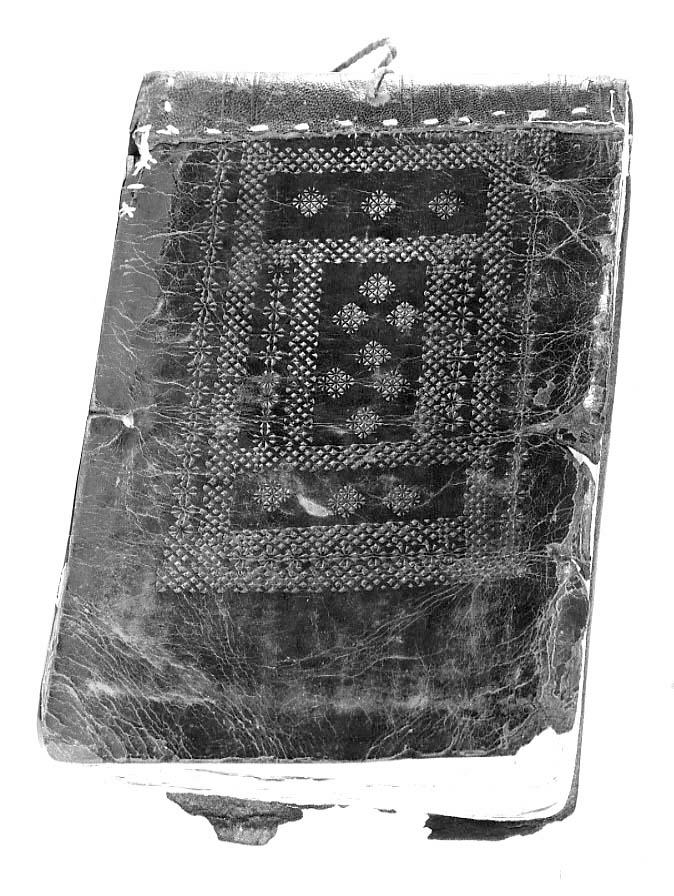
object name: manuscript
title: Manuscript with 116 Pages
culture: indian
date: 1701-1800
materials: ink, paper